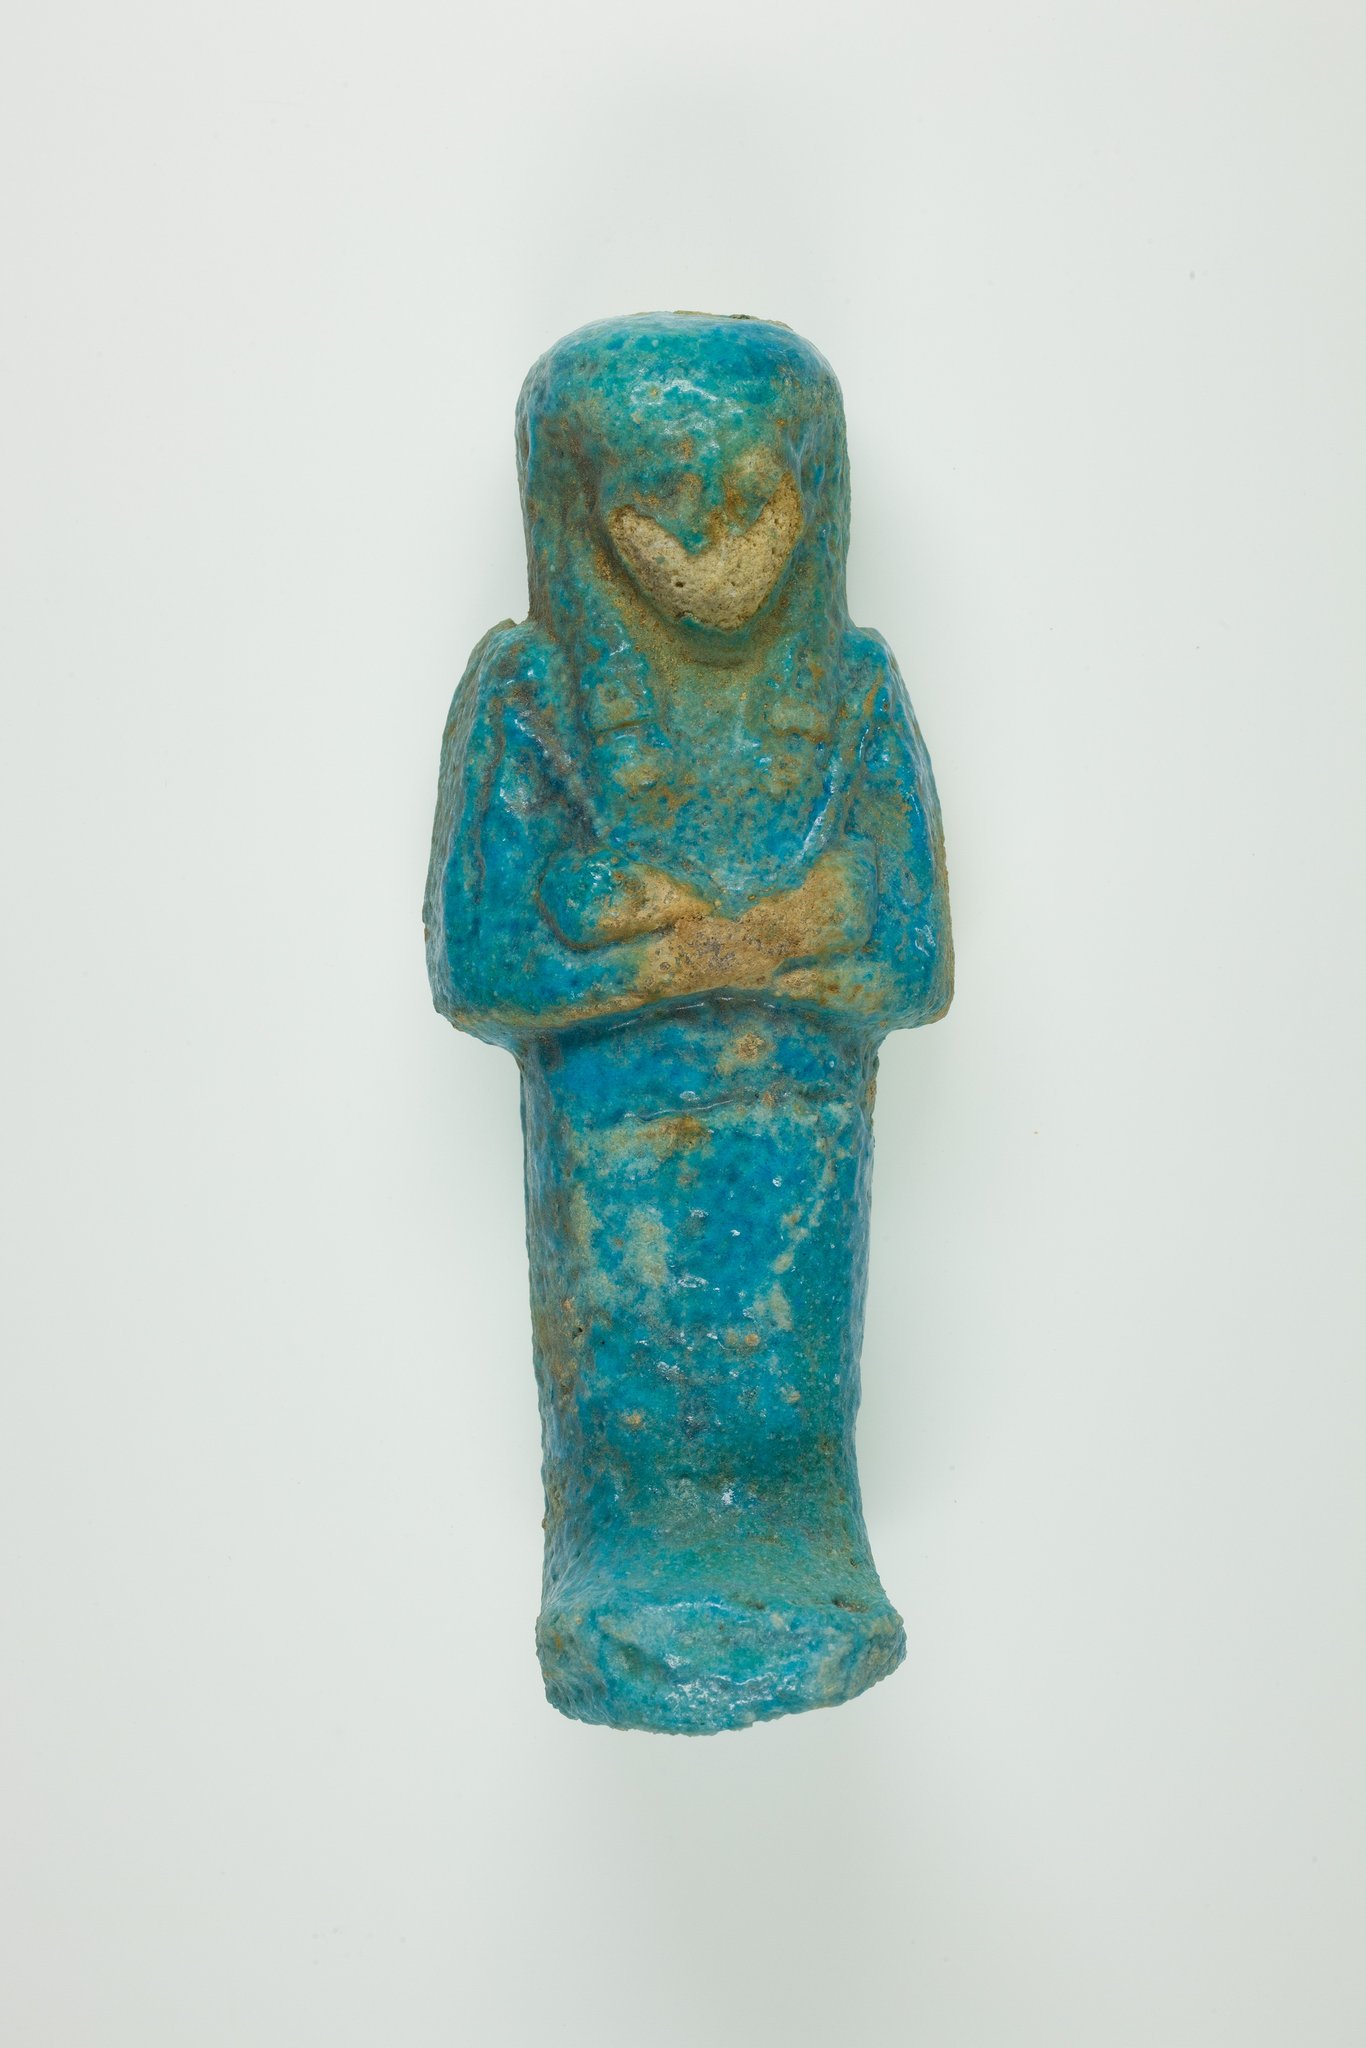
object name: worker shabti, henettawy c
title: Worker Shabti of Henettawy (C), Daughter of Isetemkheb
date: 990-970 BCE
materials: faience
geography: egypt